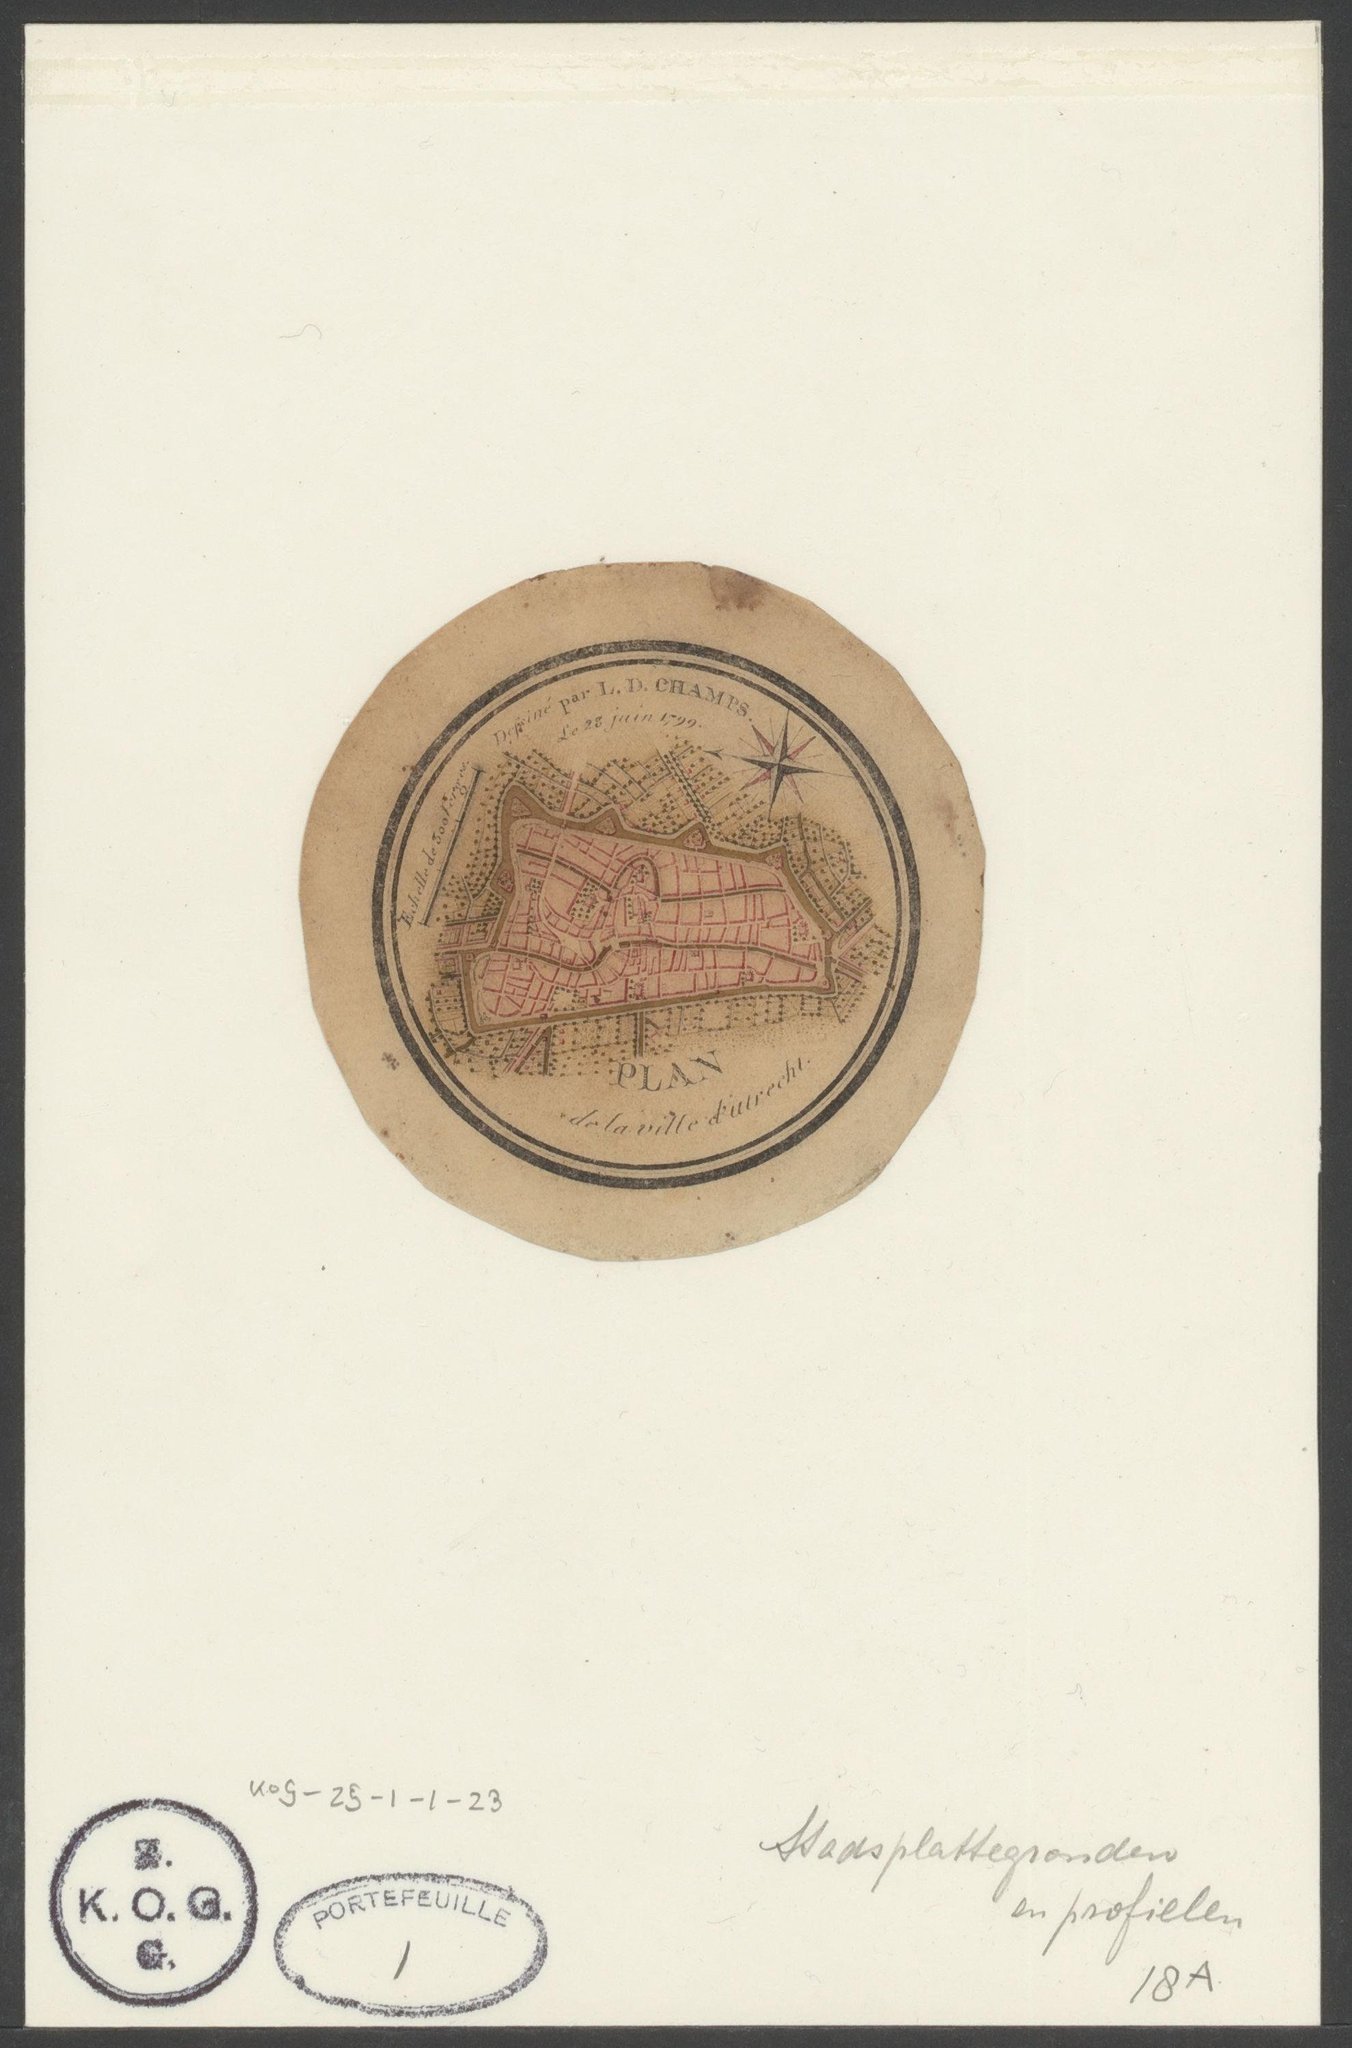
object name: print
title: Plattegrond van Utrecht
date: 1799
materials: paper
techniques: etching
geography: utrecht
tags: maps of cities, utrecht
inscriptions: collector's mark, collector's mark: Lugt 1641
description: Kleine ronde plattegrond van de stad Utrecht, 1799. Met schaalstok en kompasroos. Onderwerpsrubrieken binnen de Atlas Zeden en Gewoonten: topografie; stadsplattegronden.